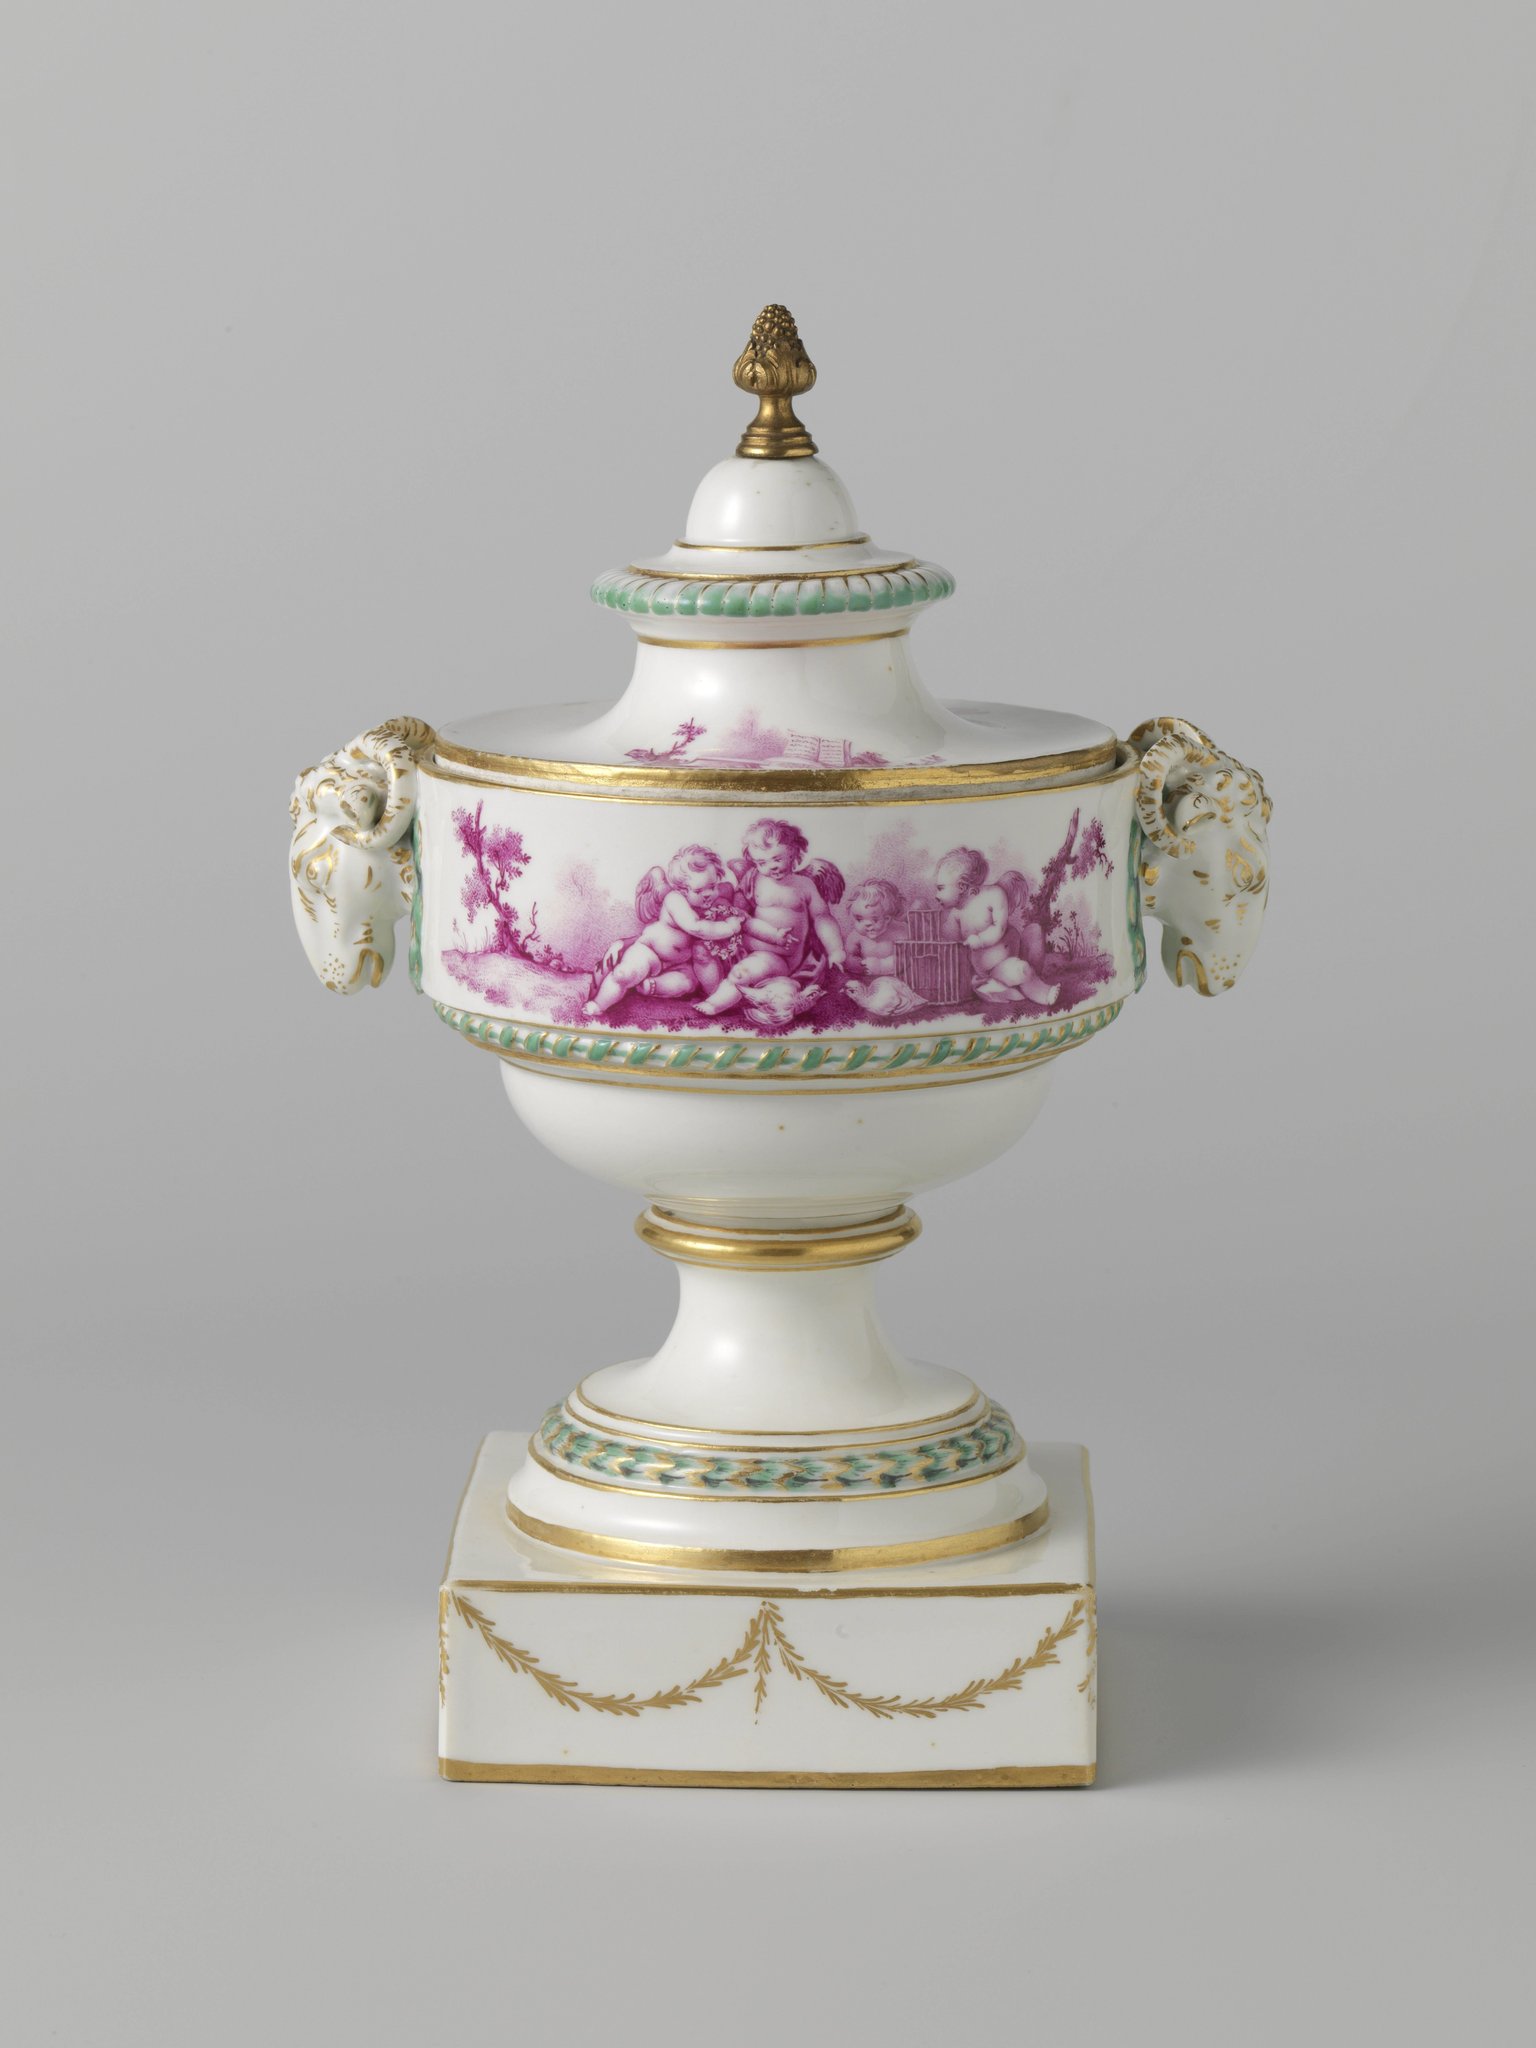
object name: vase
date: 1778-1782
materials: porcelain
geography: loosdrecht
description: The broad, straight-sided belly, strict linearity and ram’s heads on this vase are typical features of Neoclassicism. The Loosdrecht porcelain factory worked increasingly in this style over the course of its existence. This vase is one of a pair that probably graced a chimneypiece.